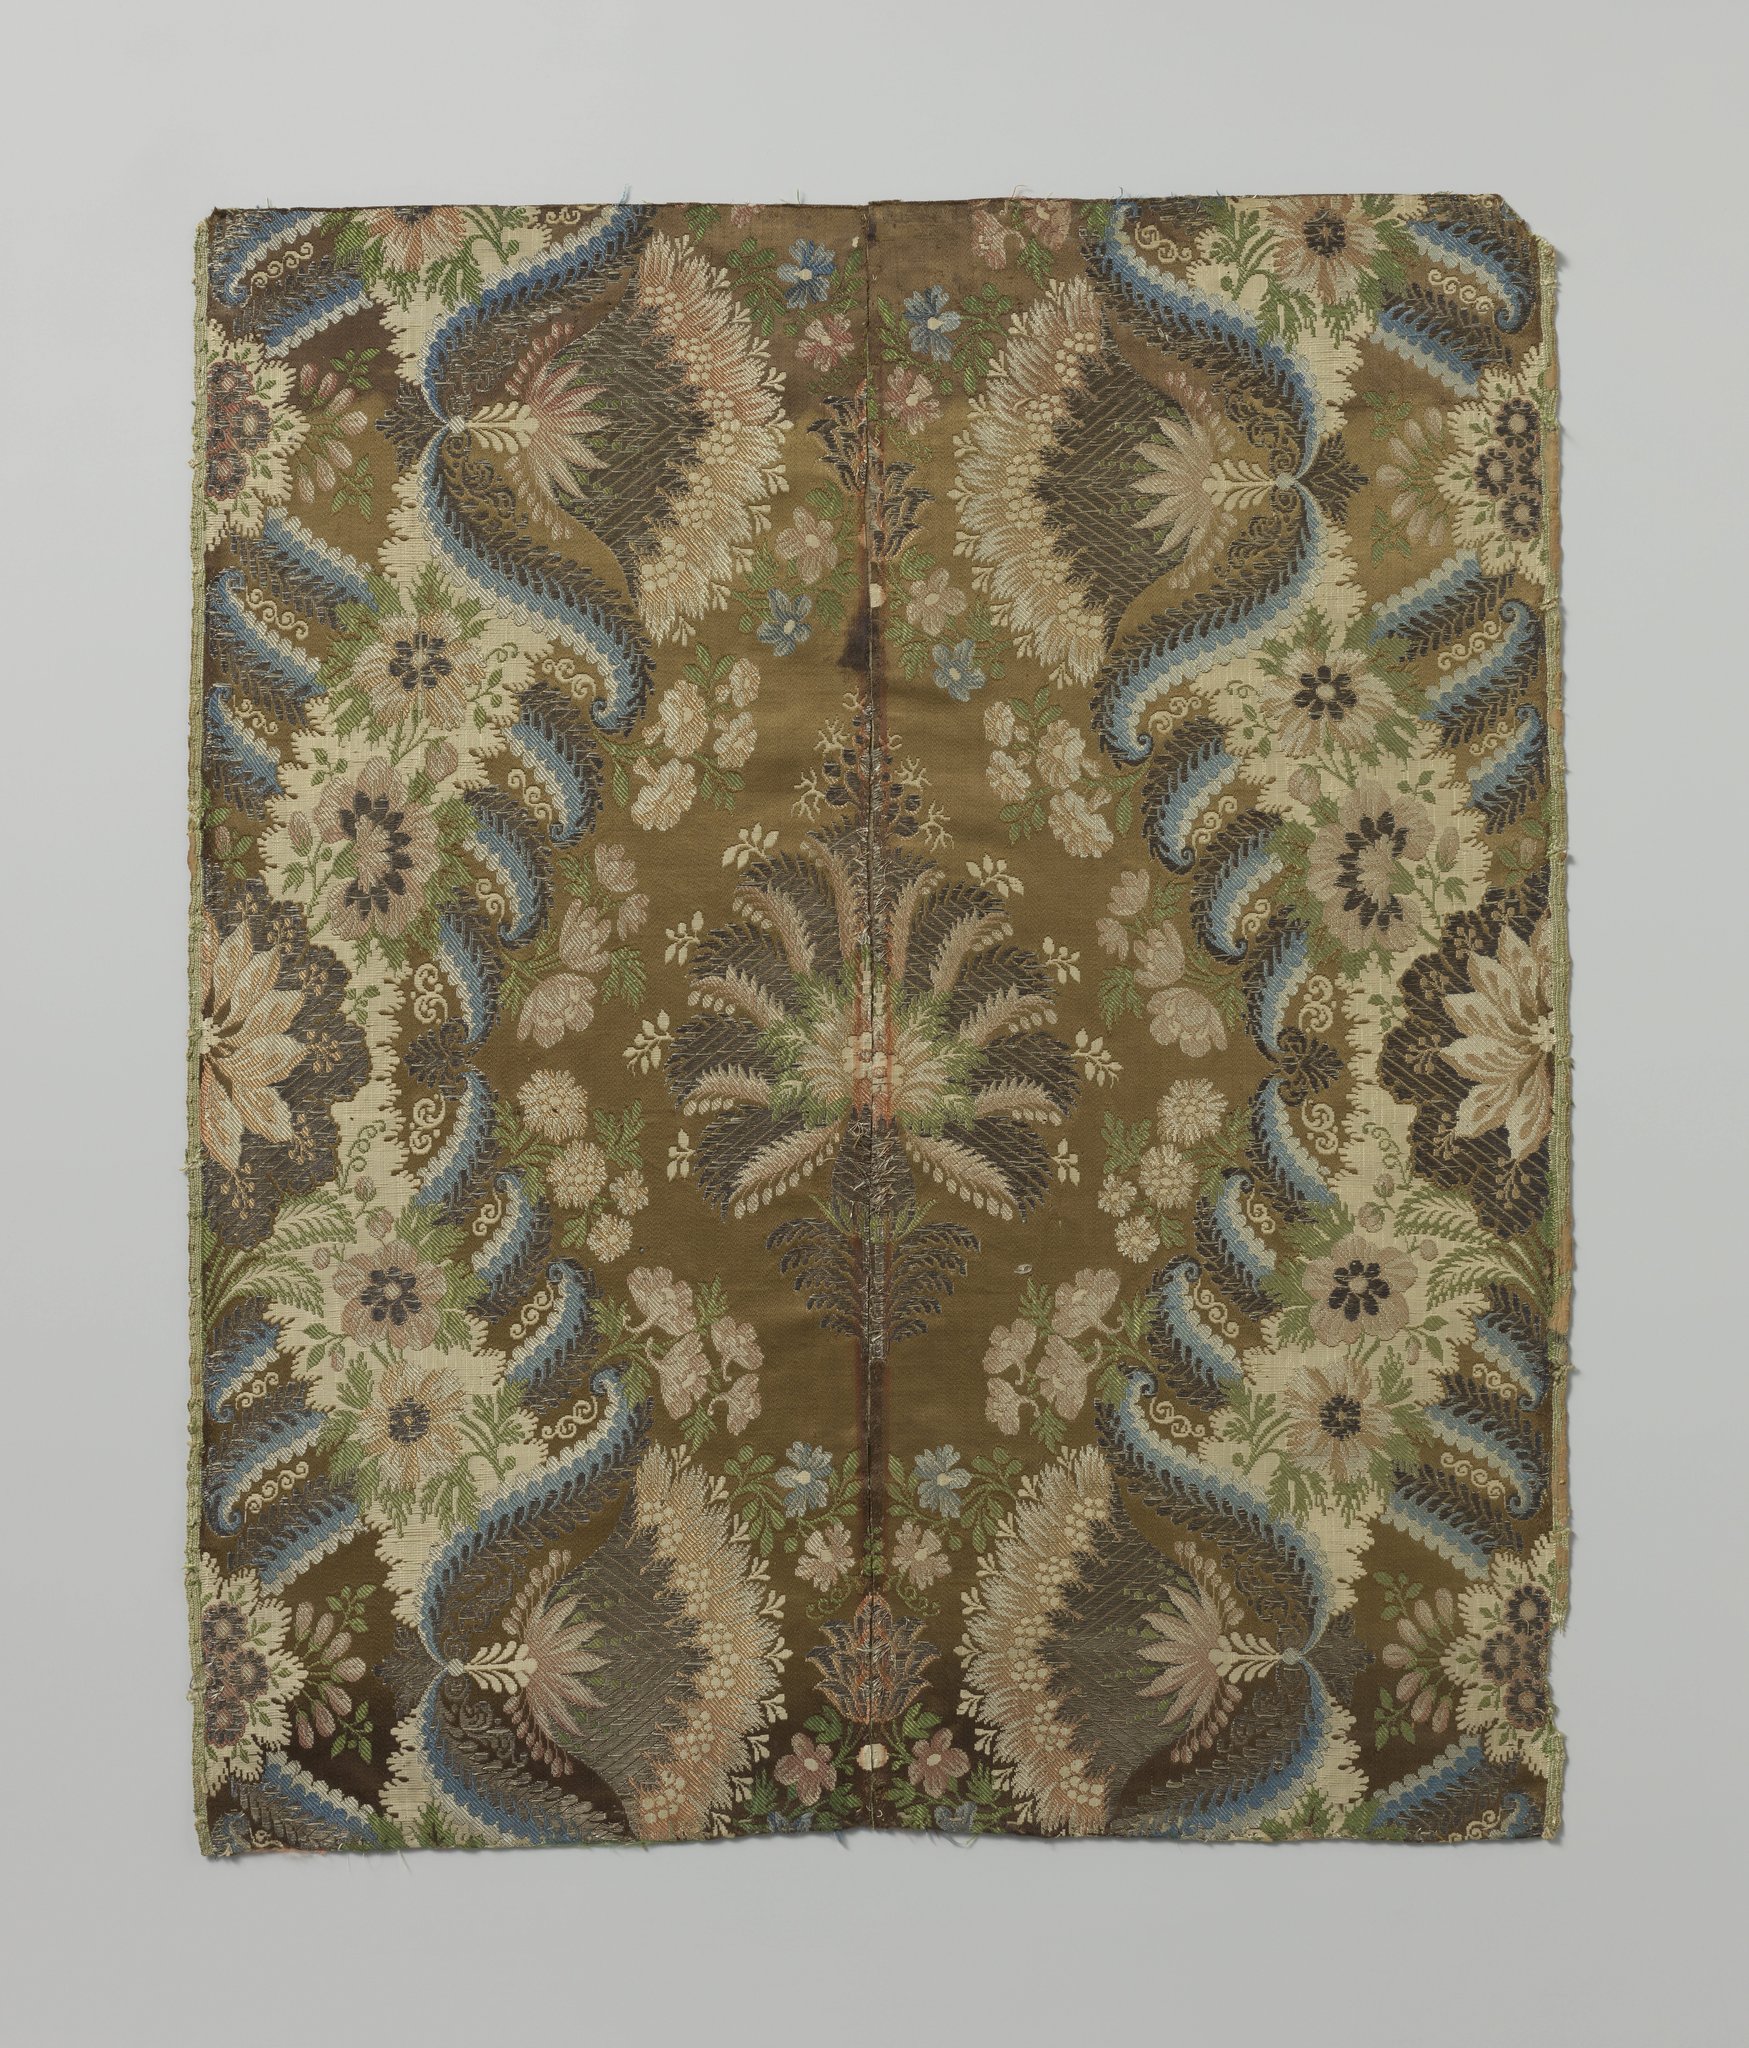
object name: fragment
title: Fragment zijden lampas in donkerbruin, wit en groen met veelkleurig patroon van granaatappel in boeketvorm met allerhande bloemen in ruitvorm er omheen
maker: Anonymous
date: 1725-1750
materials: silk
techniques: brocade, lampas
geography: netherlands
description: Fragment zijden lampas, met een donkerbruine en witte schering die afwisselend als fond dienst doen. Inslagen van wit en groen, terwijl de stof is doorschoten met rode, witte en blauwe zijde en zilverdraad. Patroon bestaat uit een bloeiende granaatappel in boeketvorm waaromheen een ruitvormige krans van bloemtakken omgeven door een golvende brede band van S-vormige figuren waartussen grote en kleine bloemen en bladeren. Twee aanelkaar genaaide delen.